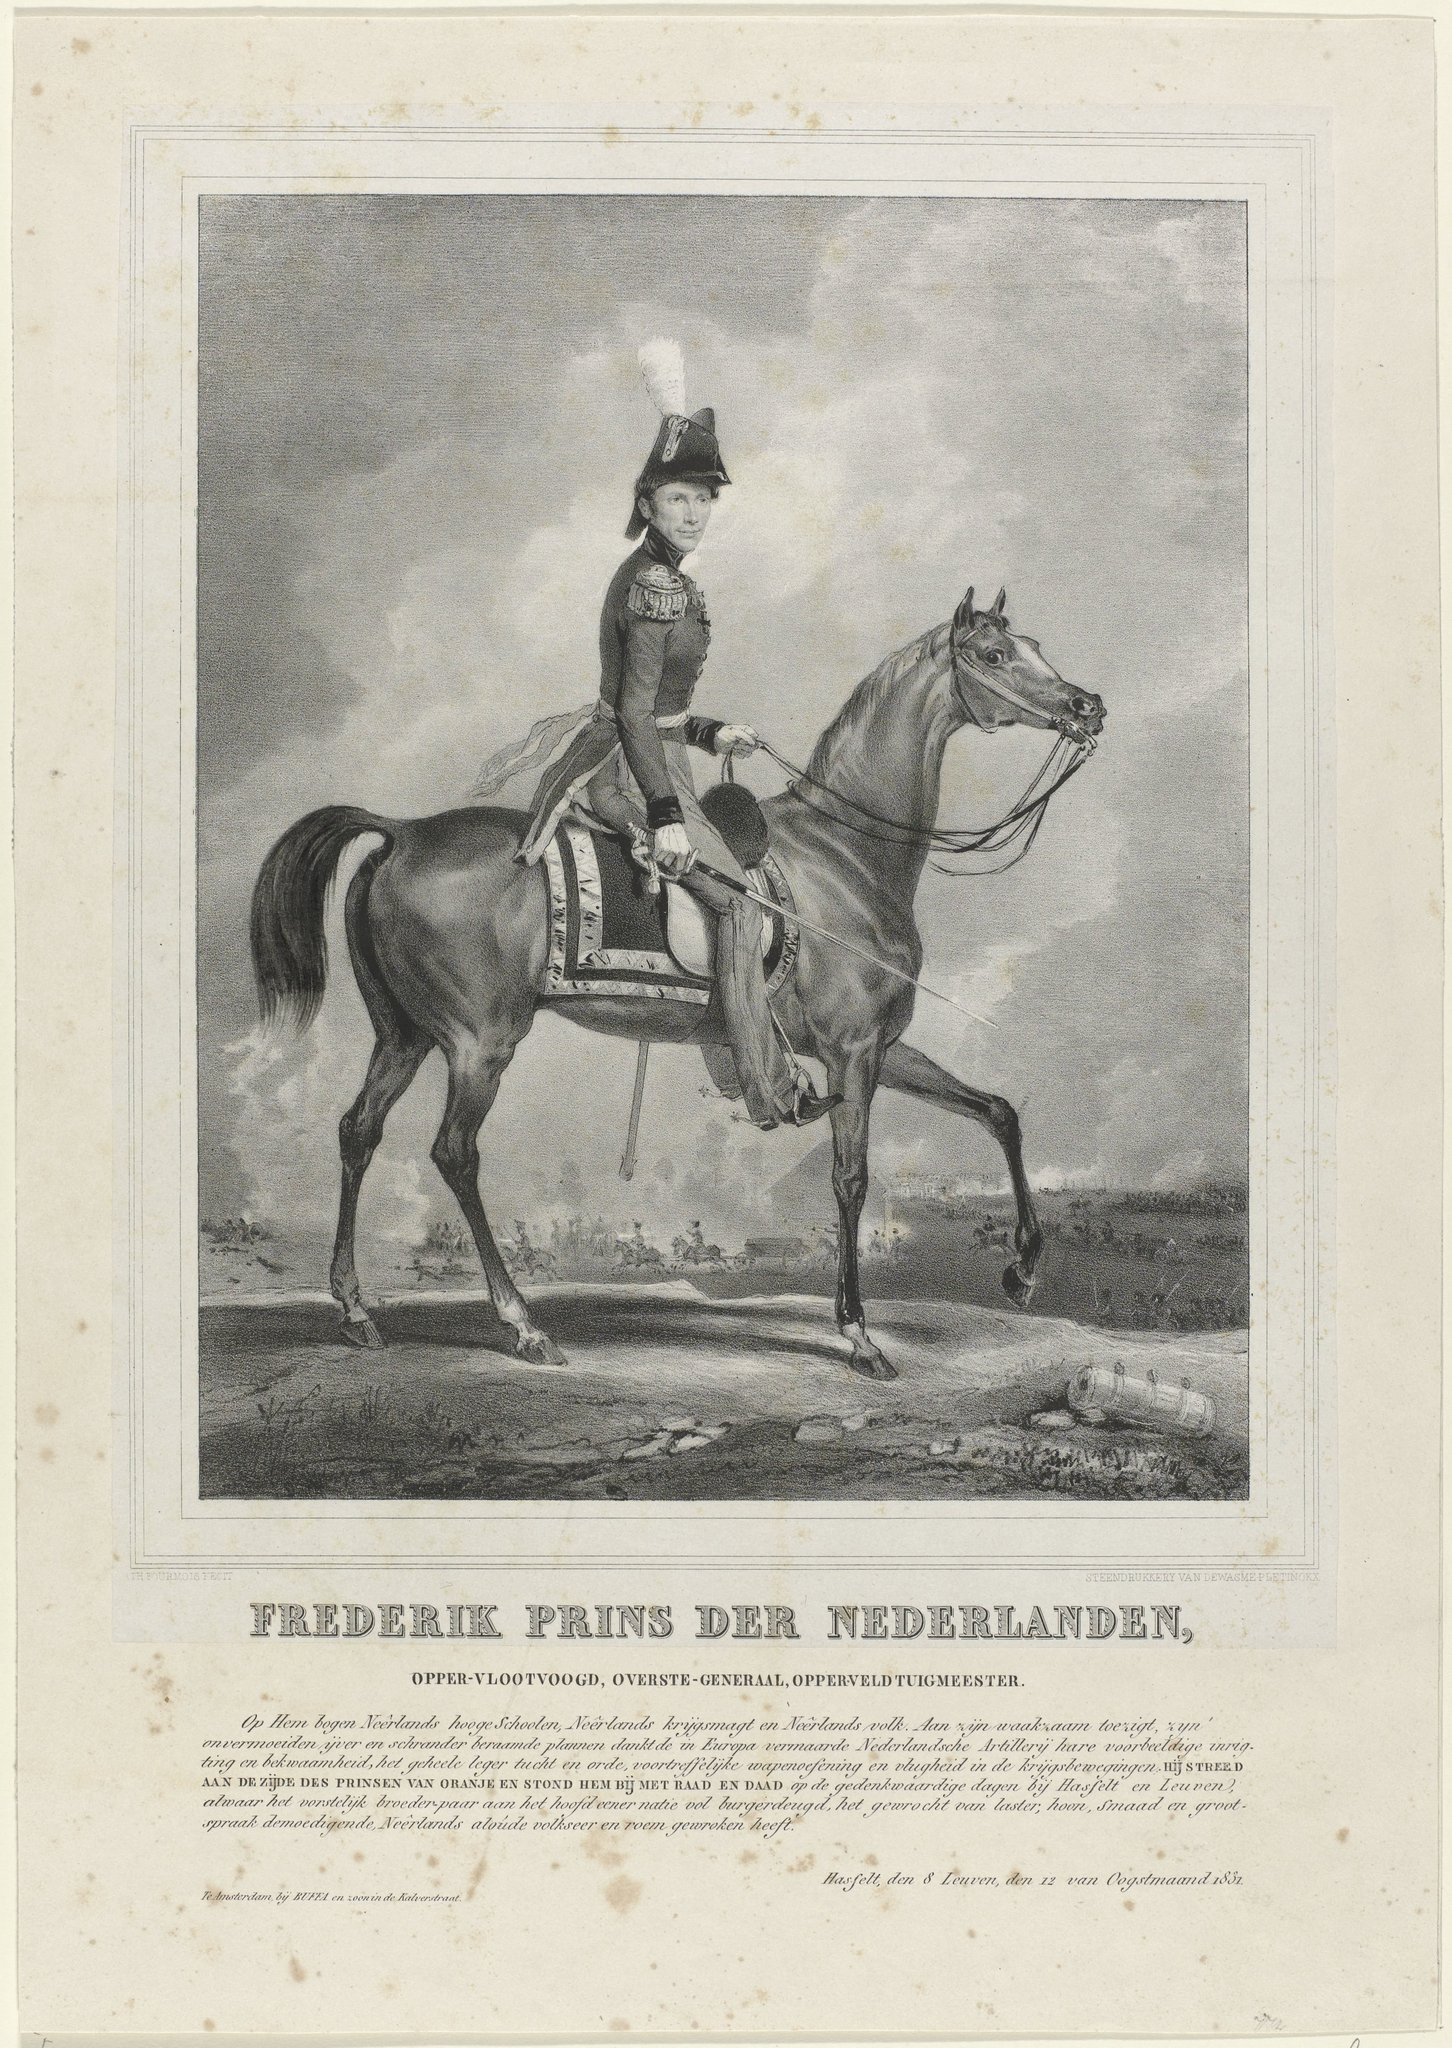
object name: print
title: Ruiterportret van Frederik, prins der Nederlanden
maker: lith. de la cour des ps. bas à bruxelles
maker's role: printer, publisher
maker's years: 1797-1851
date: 1831-1833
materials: paper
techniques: lithograph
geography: amsterdam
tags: berlin, frederik (prins der nederlanden)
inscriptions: collector's mark: Lugt 963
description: Ruiterportret van Frederik met een hoed. Op de achtergrond een veldslag. In de ondermarge zijn naam, zijn titels en zeven regels Nederlandse tekst over de Slag bij Hasselt en de Slag bij Leuven, van 8 tot 12 augustus 1831.